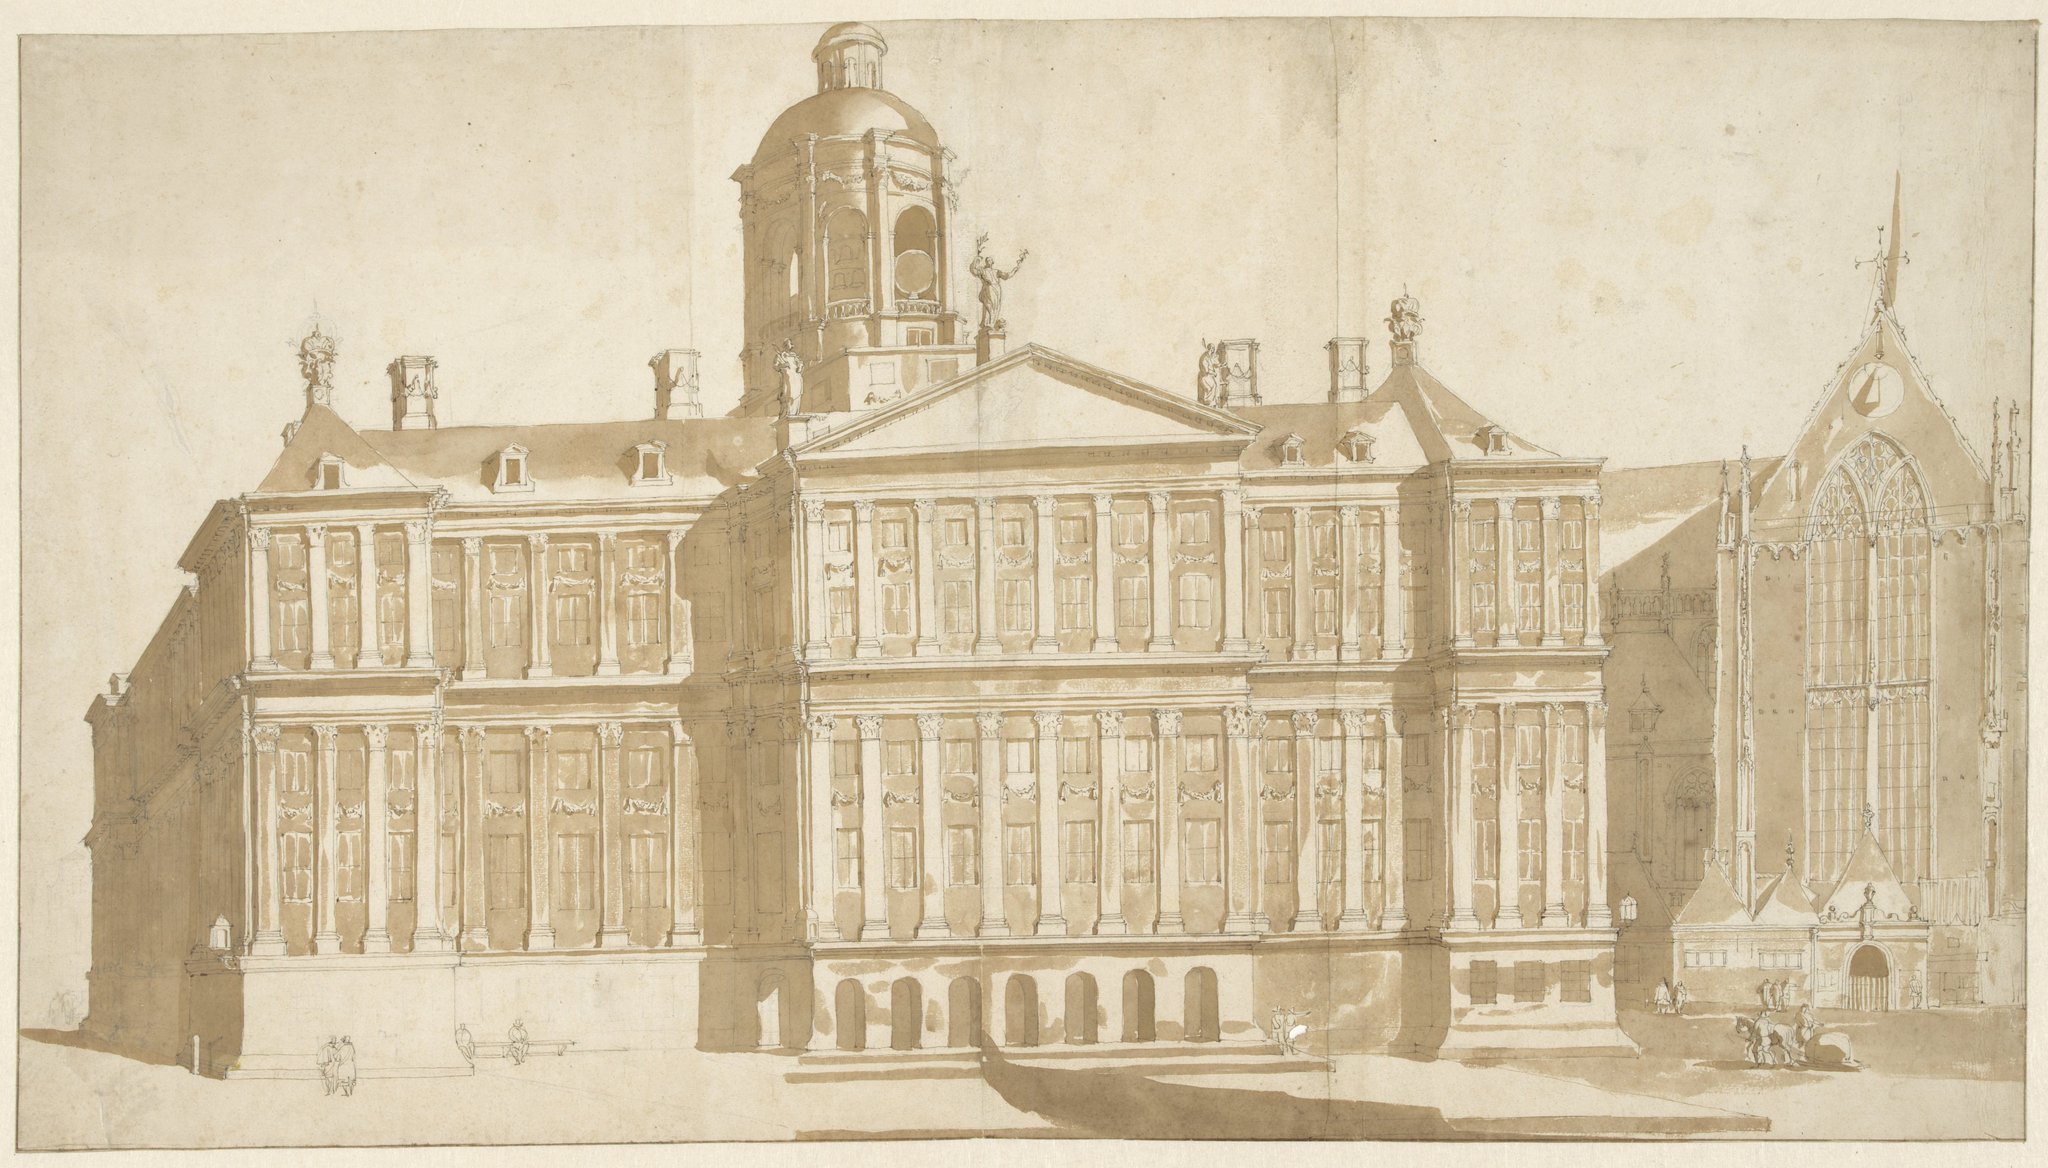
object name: drawing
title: Het nieuwe stadhuis van Amsterdam, ca. 1655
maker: jacob van der ulft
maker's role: draughtsman, painter, print maker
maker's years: 1627-1689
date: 1648-1689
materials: ink, paper, pencil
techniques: brush, pen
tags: church (exterior), townhall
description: Het nieuwe stadhuis van Amsterdam, gezien van voren, rechts de Nieuwe Kerk, op de voorgrond enkele figuurtjes. Ingewijd in 1655.